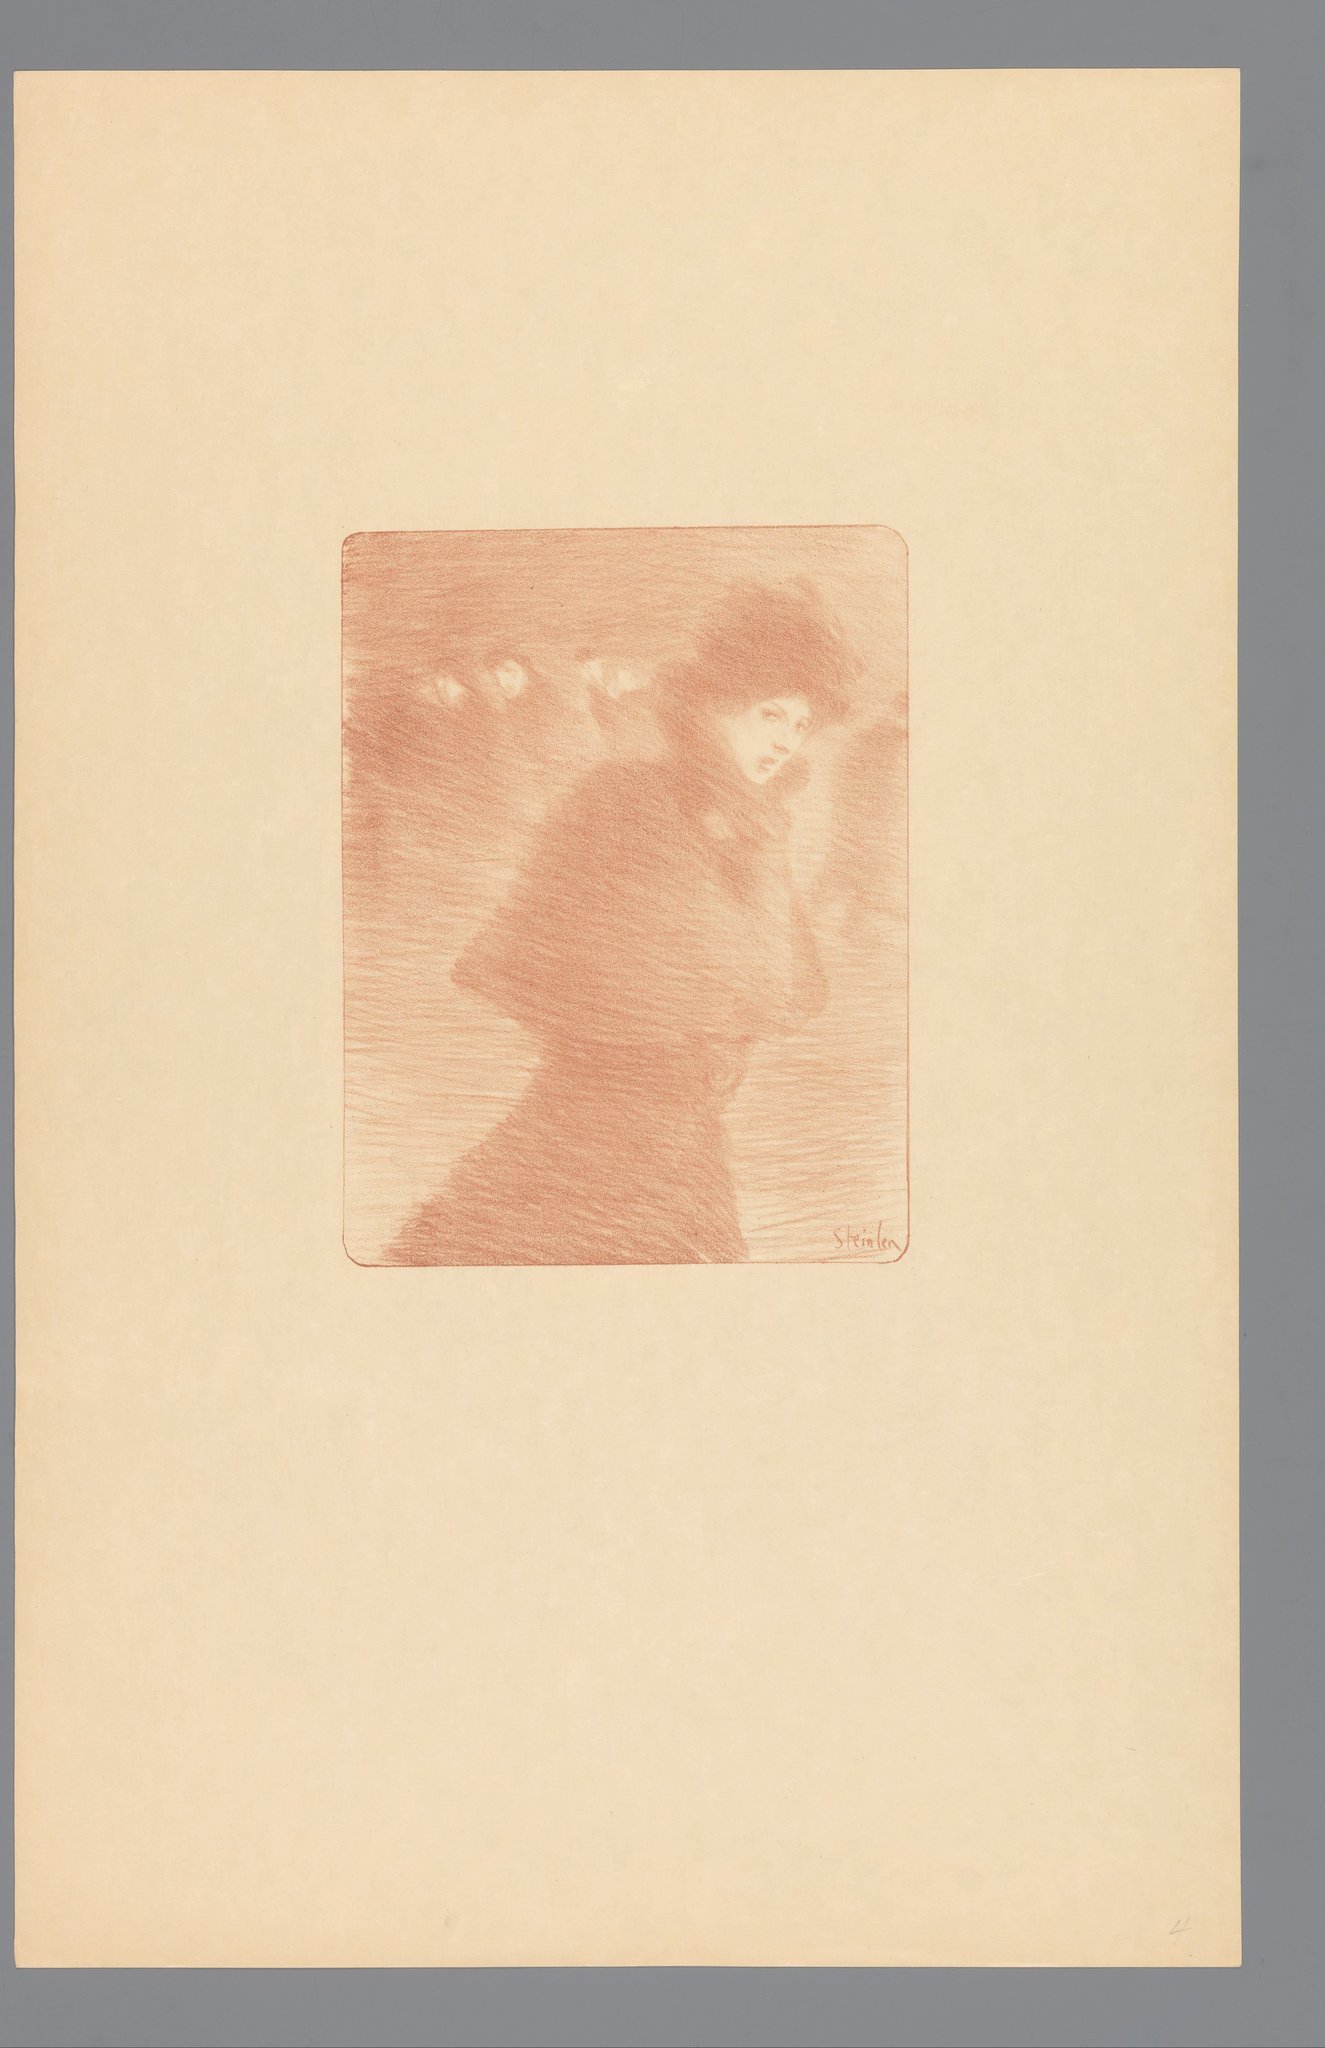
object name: print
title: Vrouwenliederen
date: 1897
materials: paper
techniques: lithograph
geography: paris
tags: head-gear, female sex; woman, coat, cape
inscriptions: collector's mark: Lugt 2760, collector's mark: Lugt 2228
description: Een dame, van opzij gezien, in matelot met hoed op het hoofd, naar rechts lopend. Op de achtergrond, vaag te zien, enkele passanten. Rechtsonder gesigneerd 'Steinlen'. No. 4 uit een serie van 15 litho's voor de map 'Chansons de Femmes' van Paul Delmet.